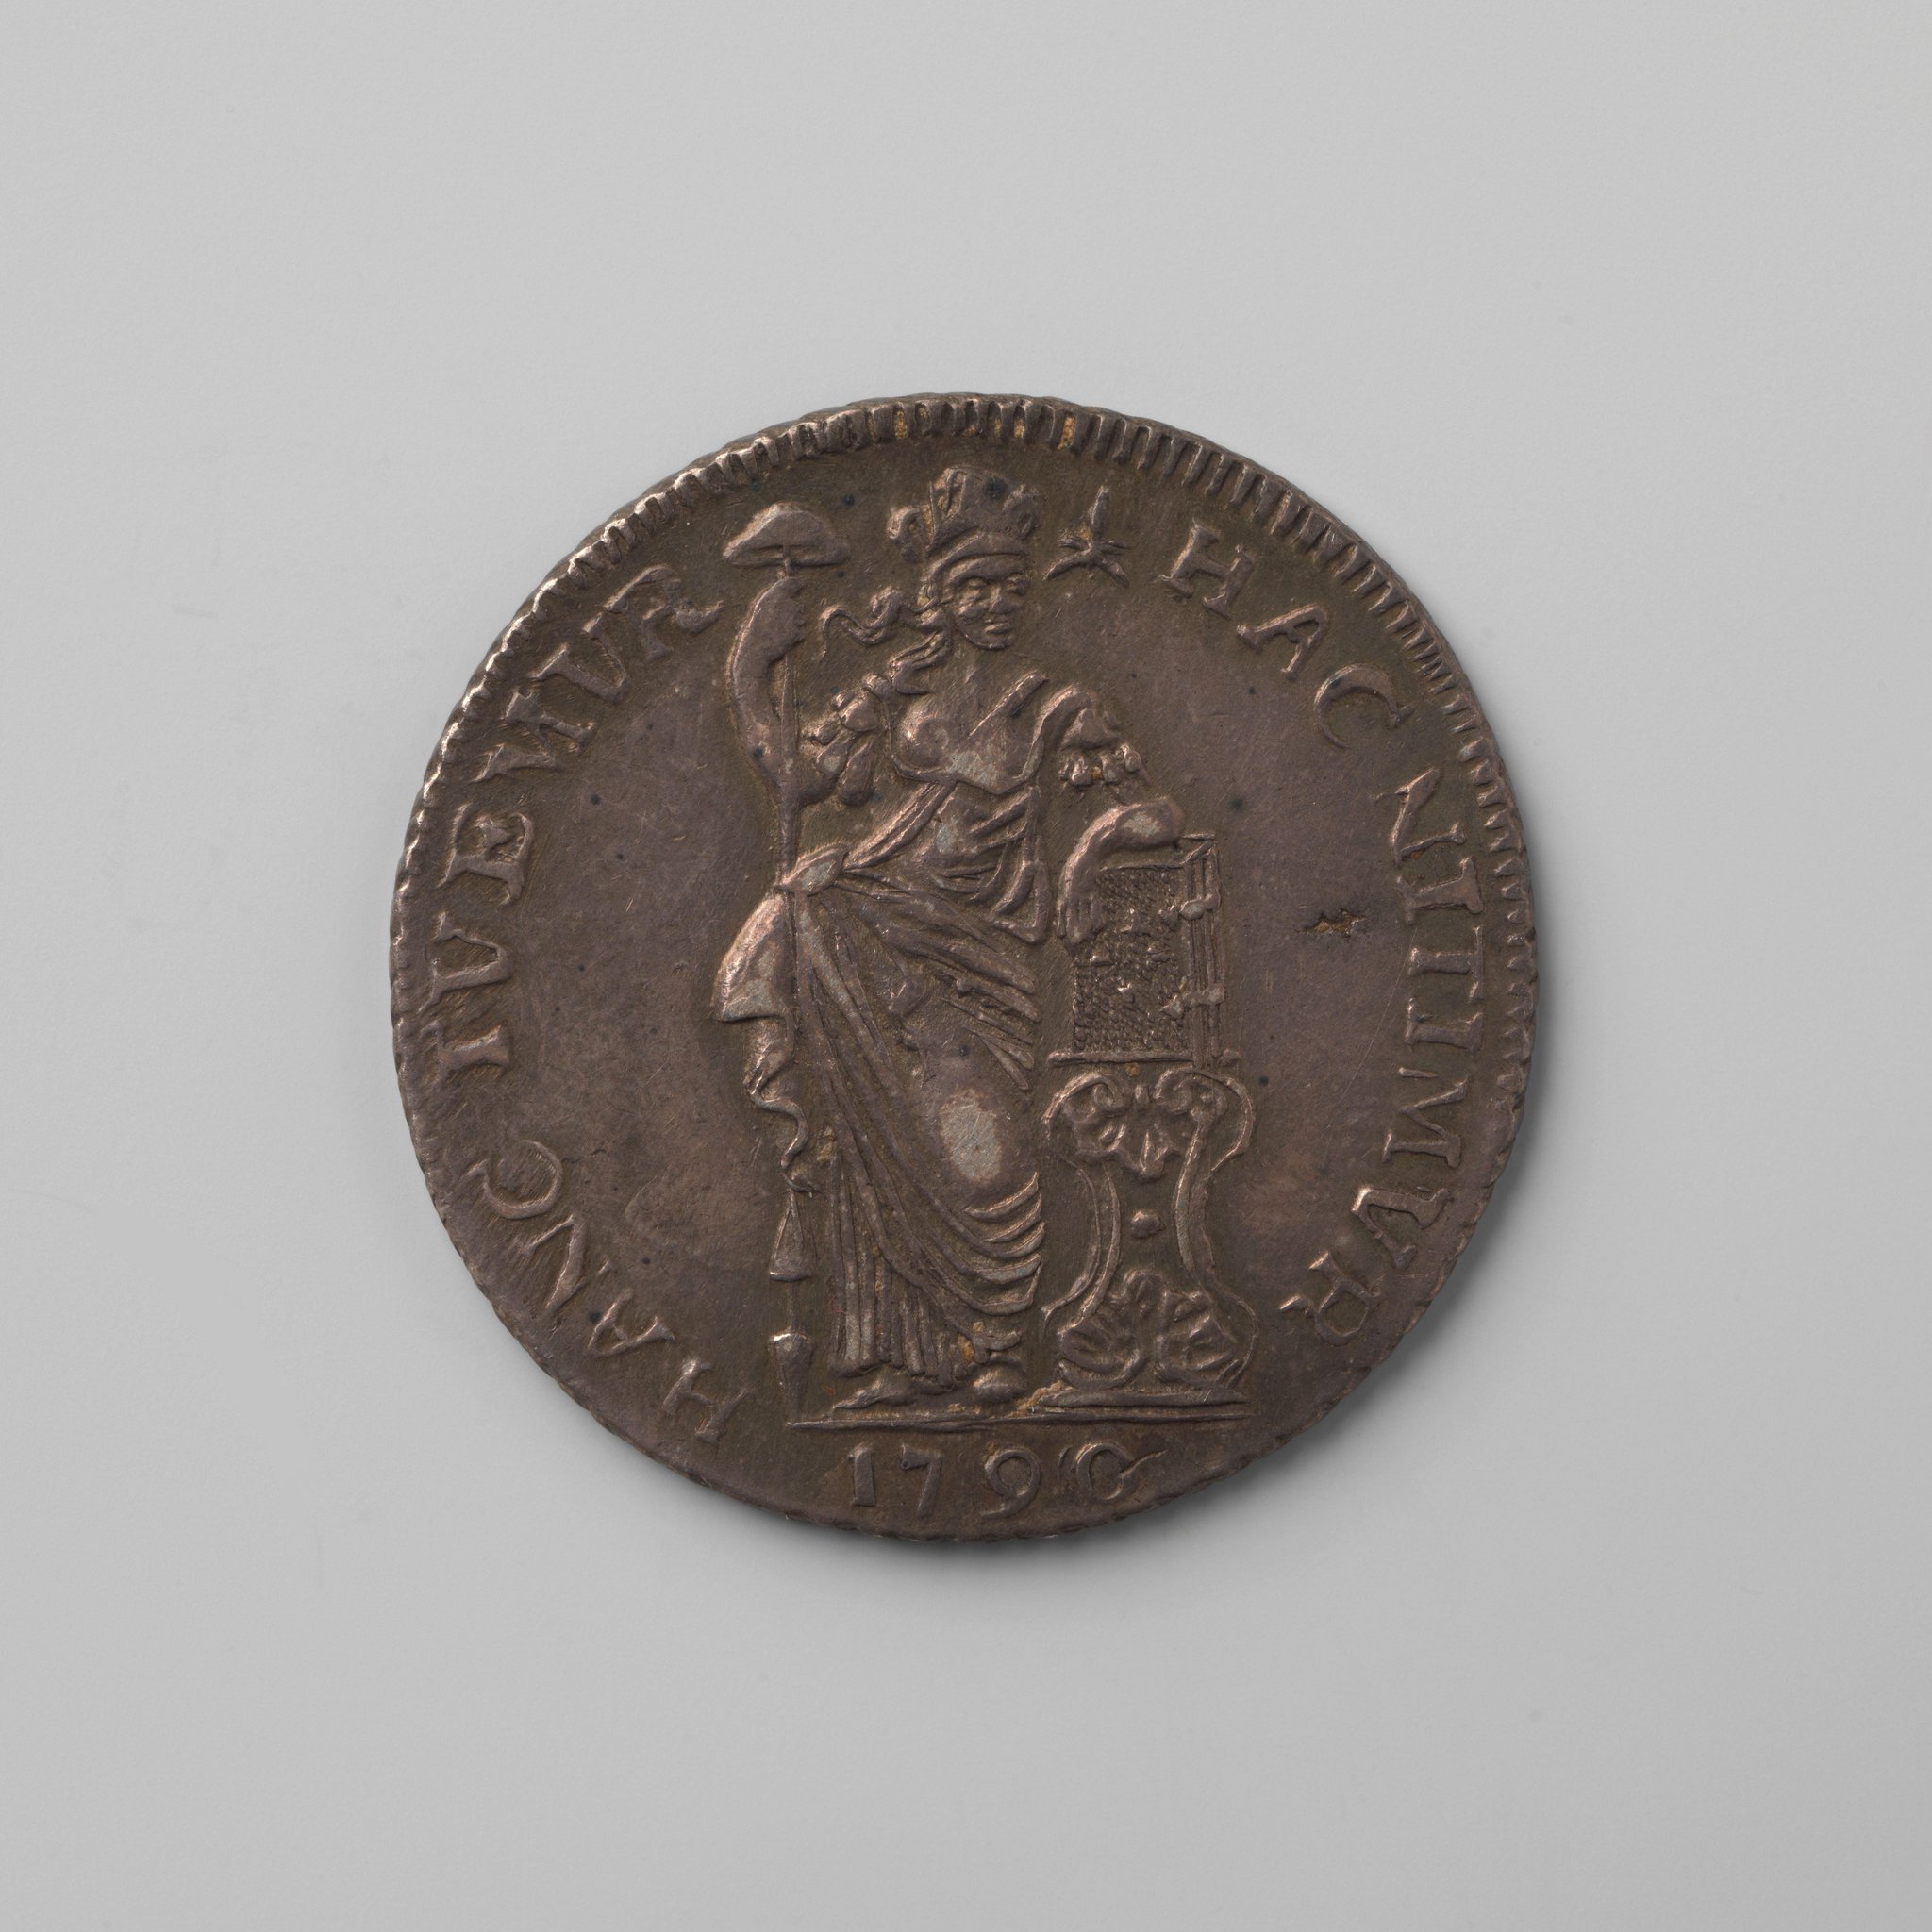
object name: coin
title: Gulden van de VOC uit Gelderland,1790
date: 1790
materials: silver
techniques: striking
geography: harderwijk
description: Zilveren munt. Voorzijde: tussen waarde-aanduiding I Gl gekroond generaliteitswapenschild, waaronder cartouche, waarin monogram van de VOC. Keerzijde: Nederlandse maagd met speer, waarop vrijheidshoed, leunend op een bijbel op een altaar. Jaartal in afsnede. Kabelrand.